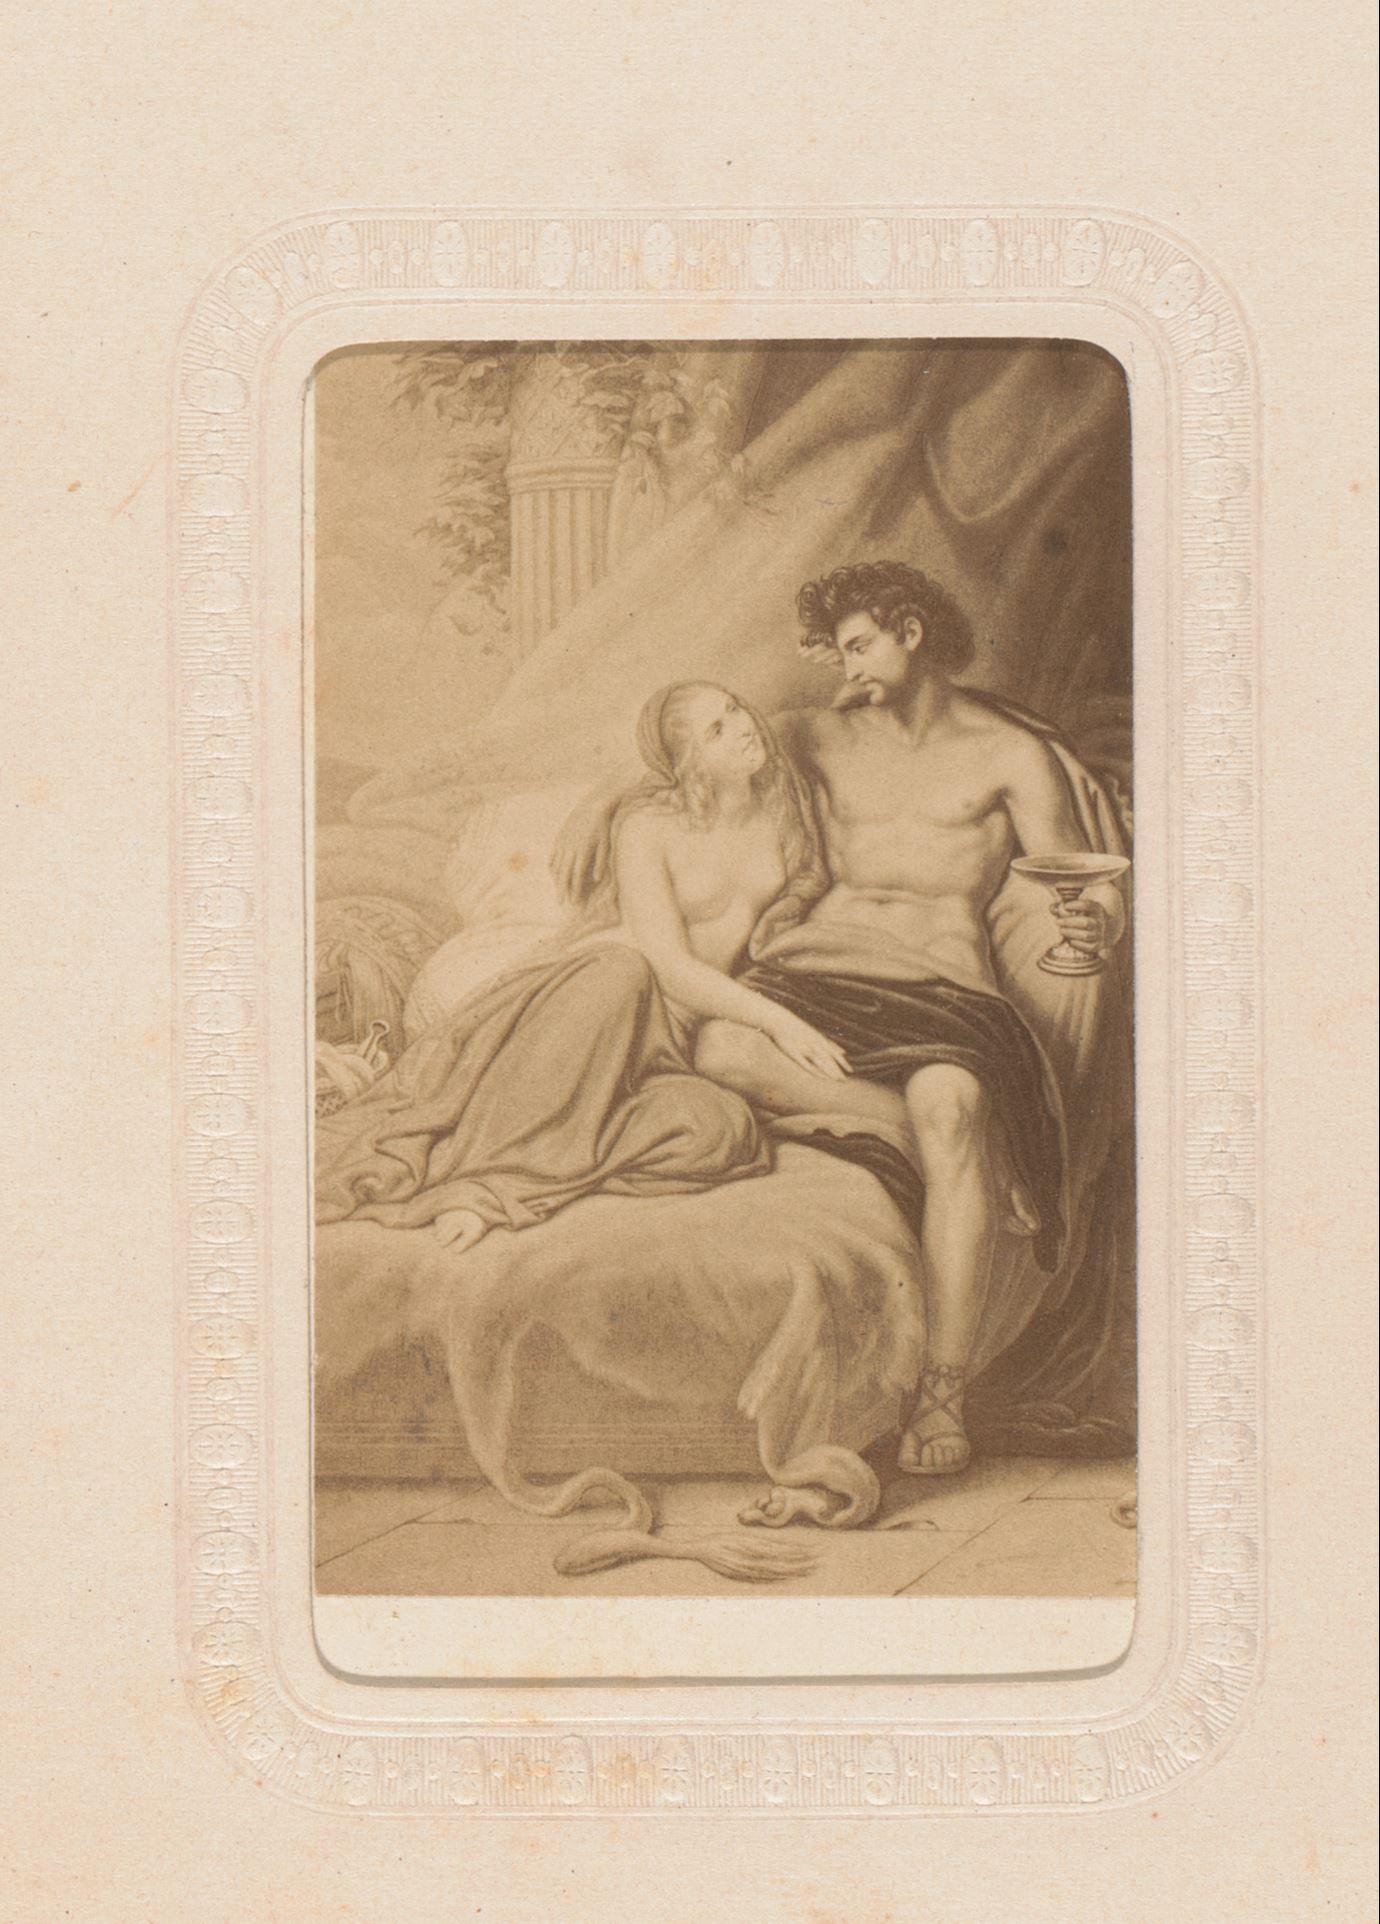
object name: album leaf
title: Fotoreproductie van een schilderij met een zittend halfnaakt paar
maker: Anonymous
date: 1855-1865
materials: cardboard, photographic support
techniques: albumen print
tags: the (nude) human figure; 'corpo humano' (ripa), couple of lovers